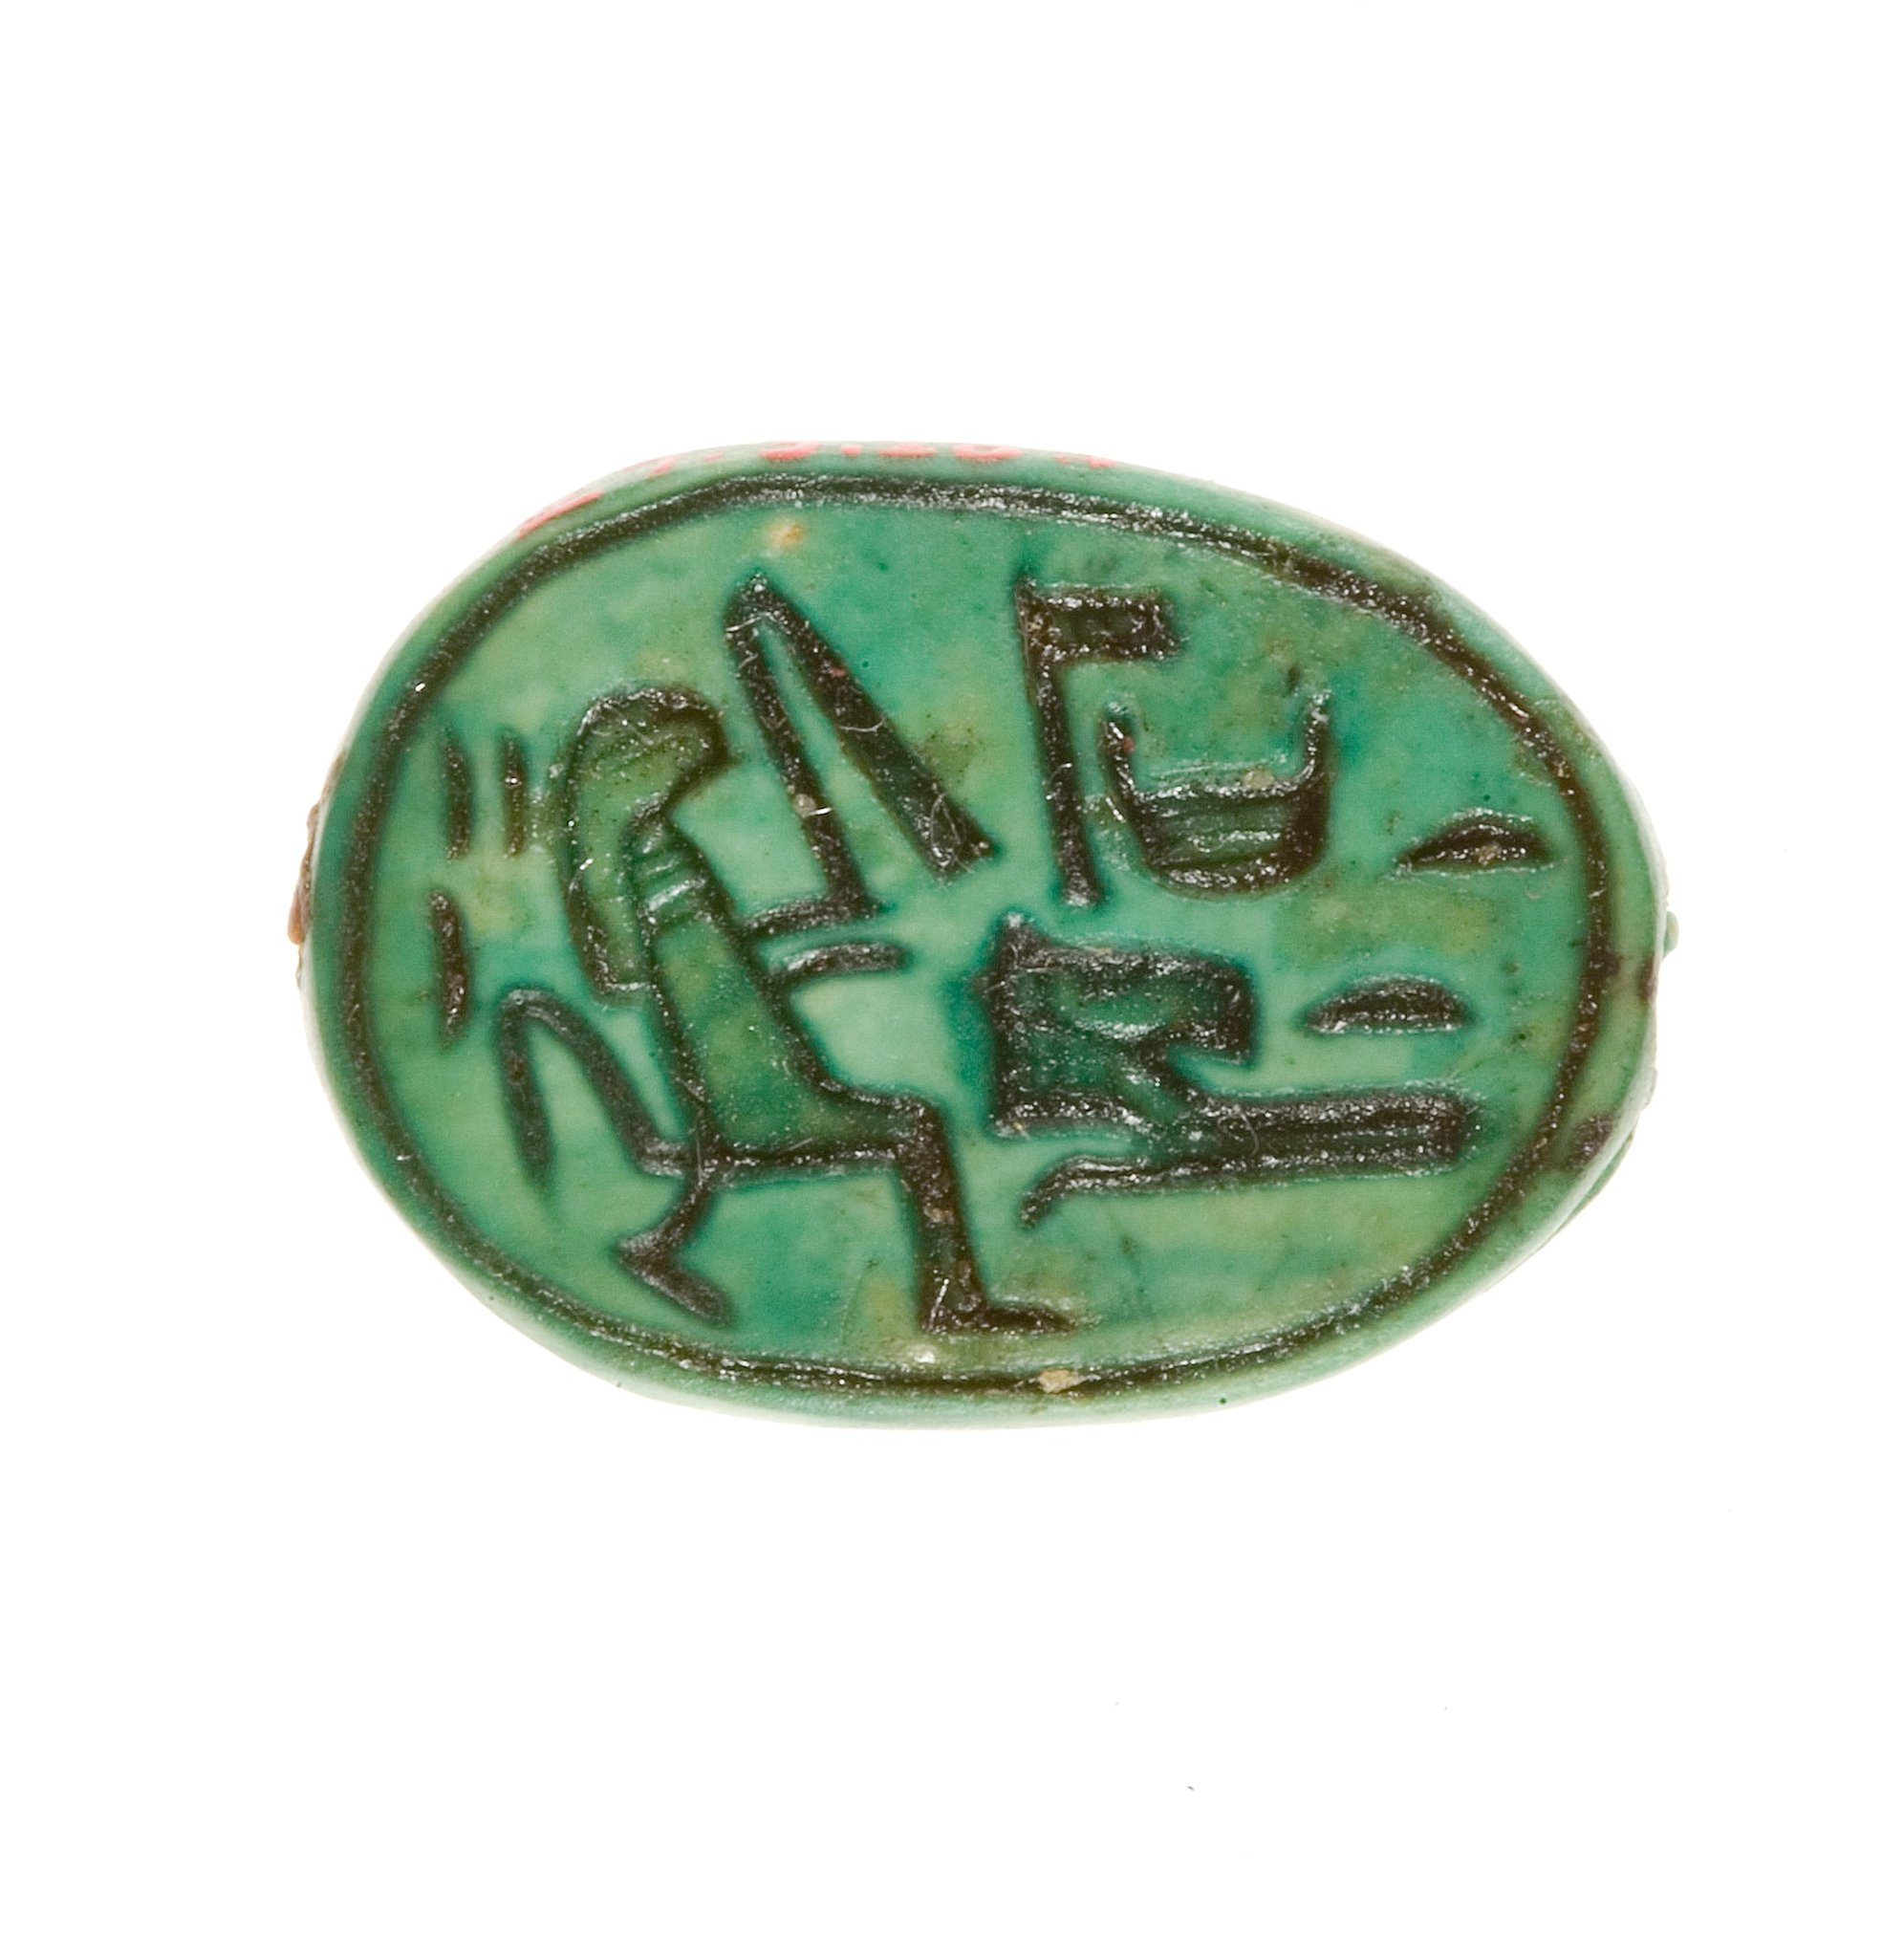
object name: scarab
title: Scarab Inscribed for the God's Wife Hatshepsut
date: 1479-1458 BCE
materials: stone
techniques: glazing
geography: egypt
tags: hieroglyphs,scarabs